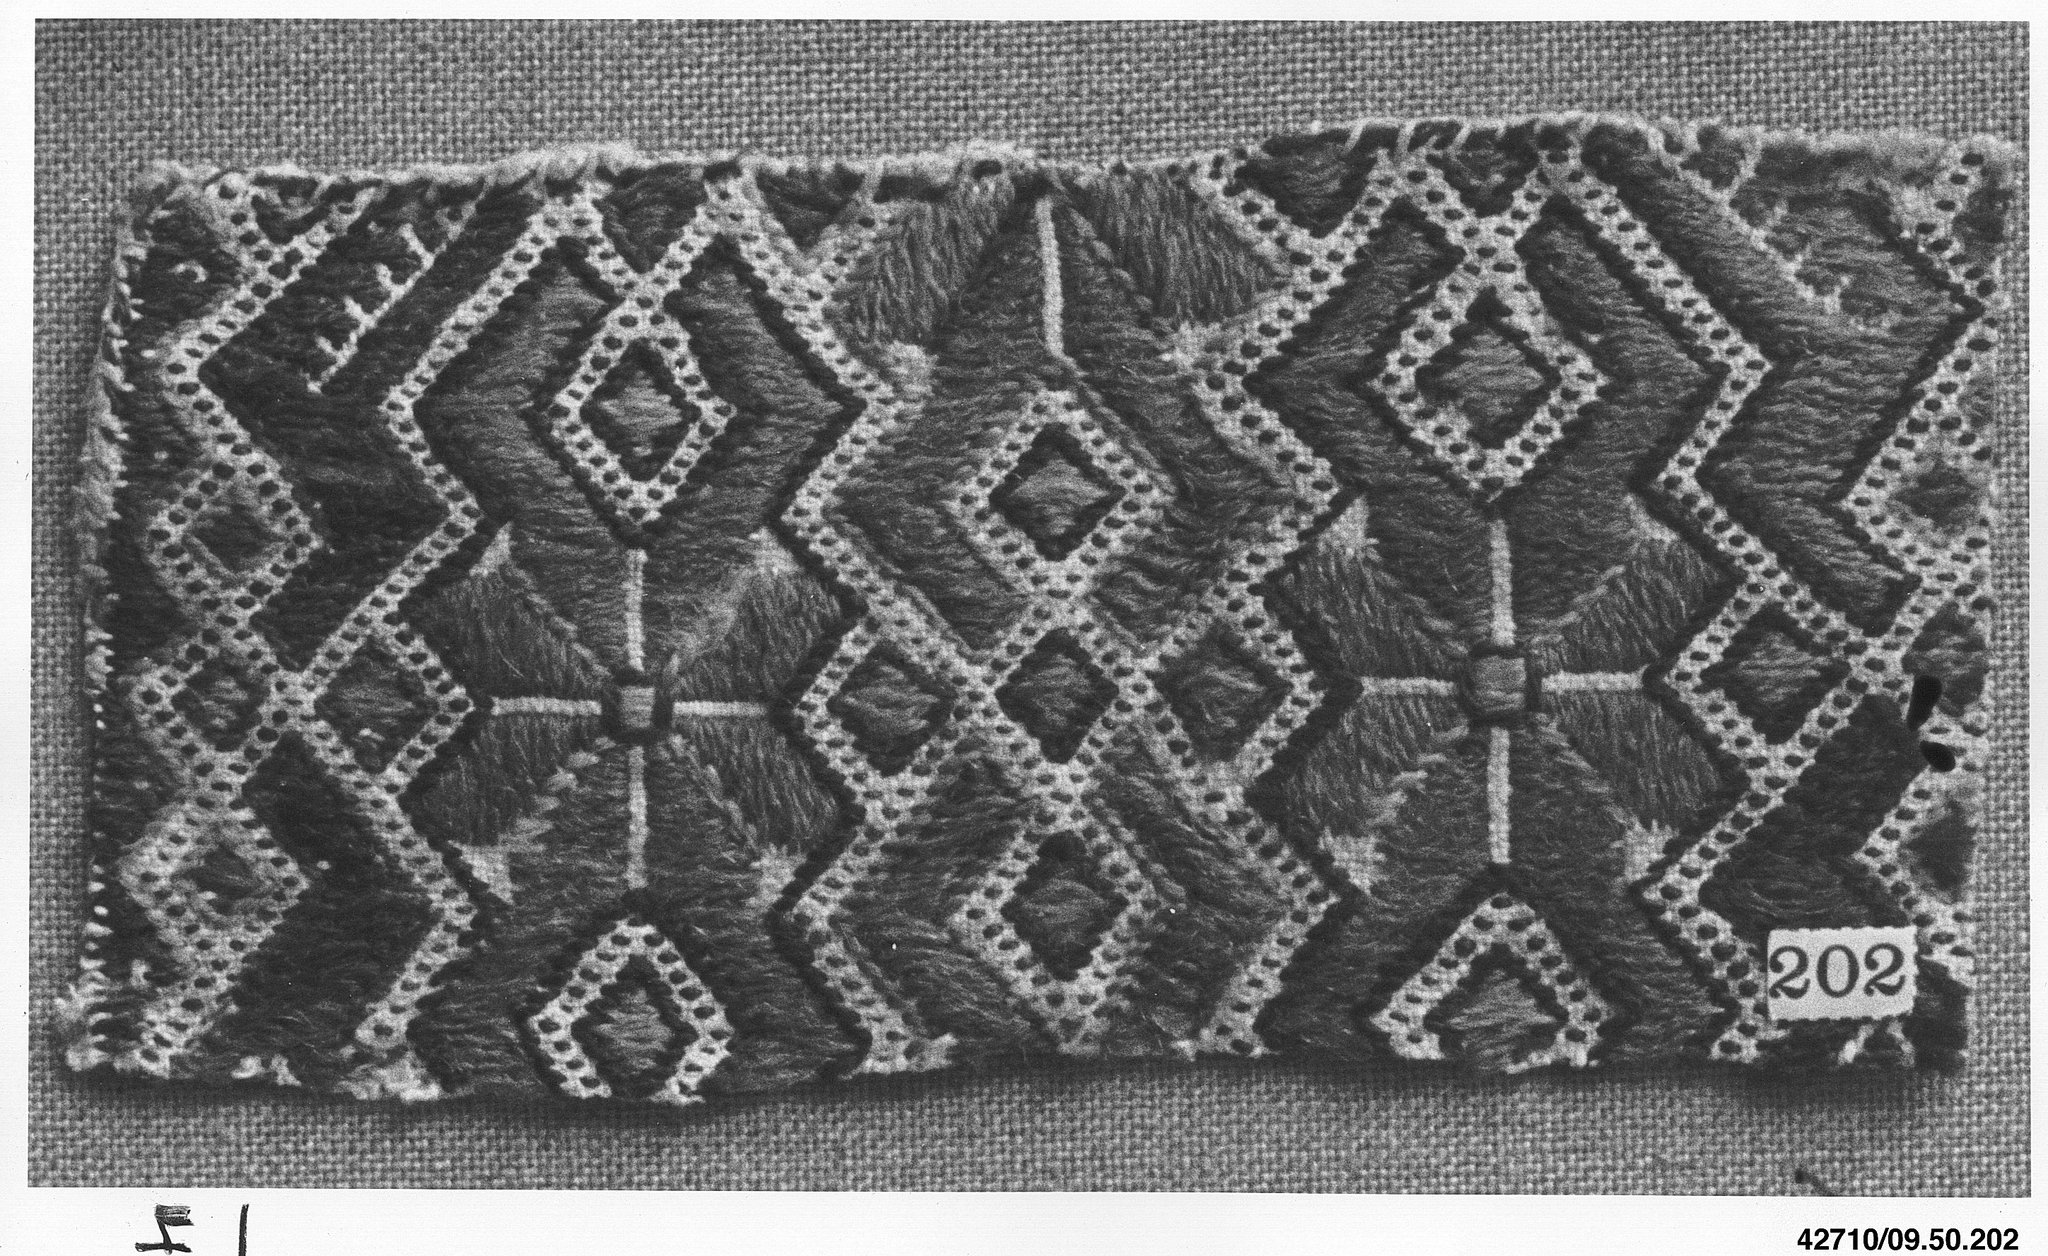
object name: costume fragment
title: Peasant costume fragment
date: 1801-1900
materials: canvas, wool